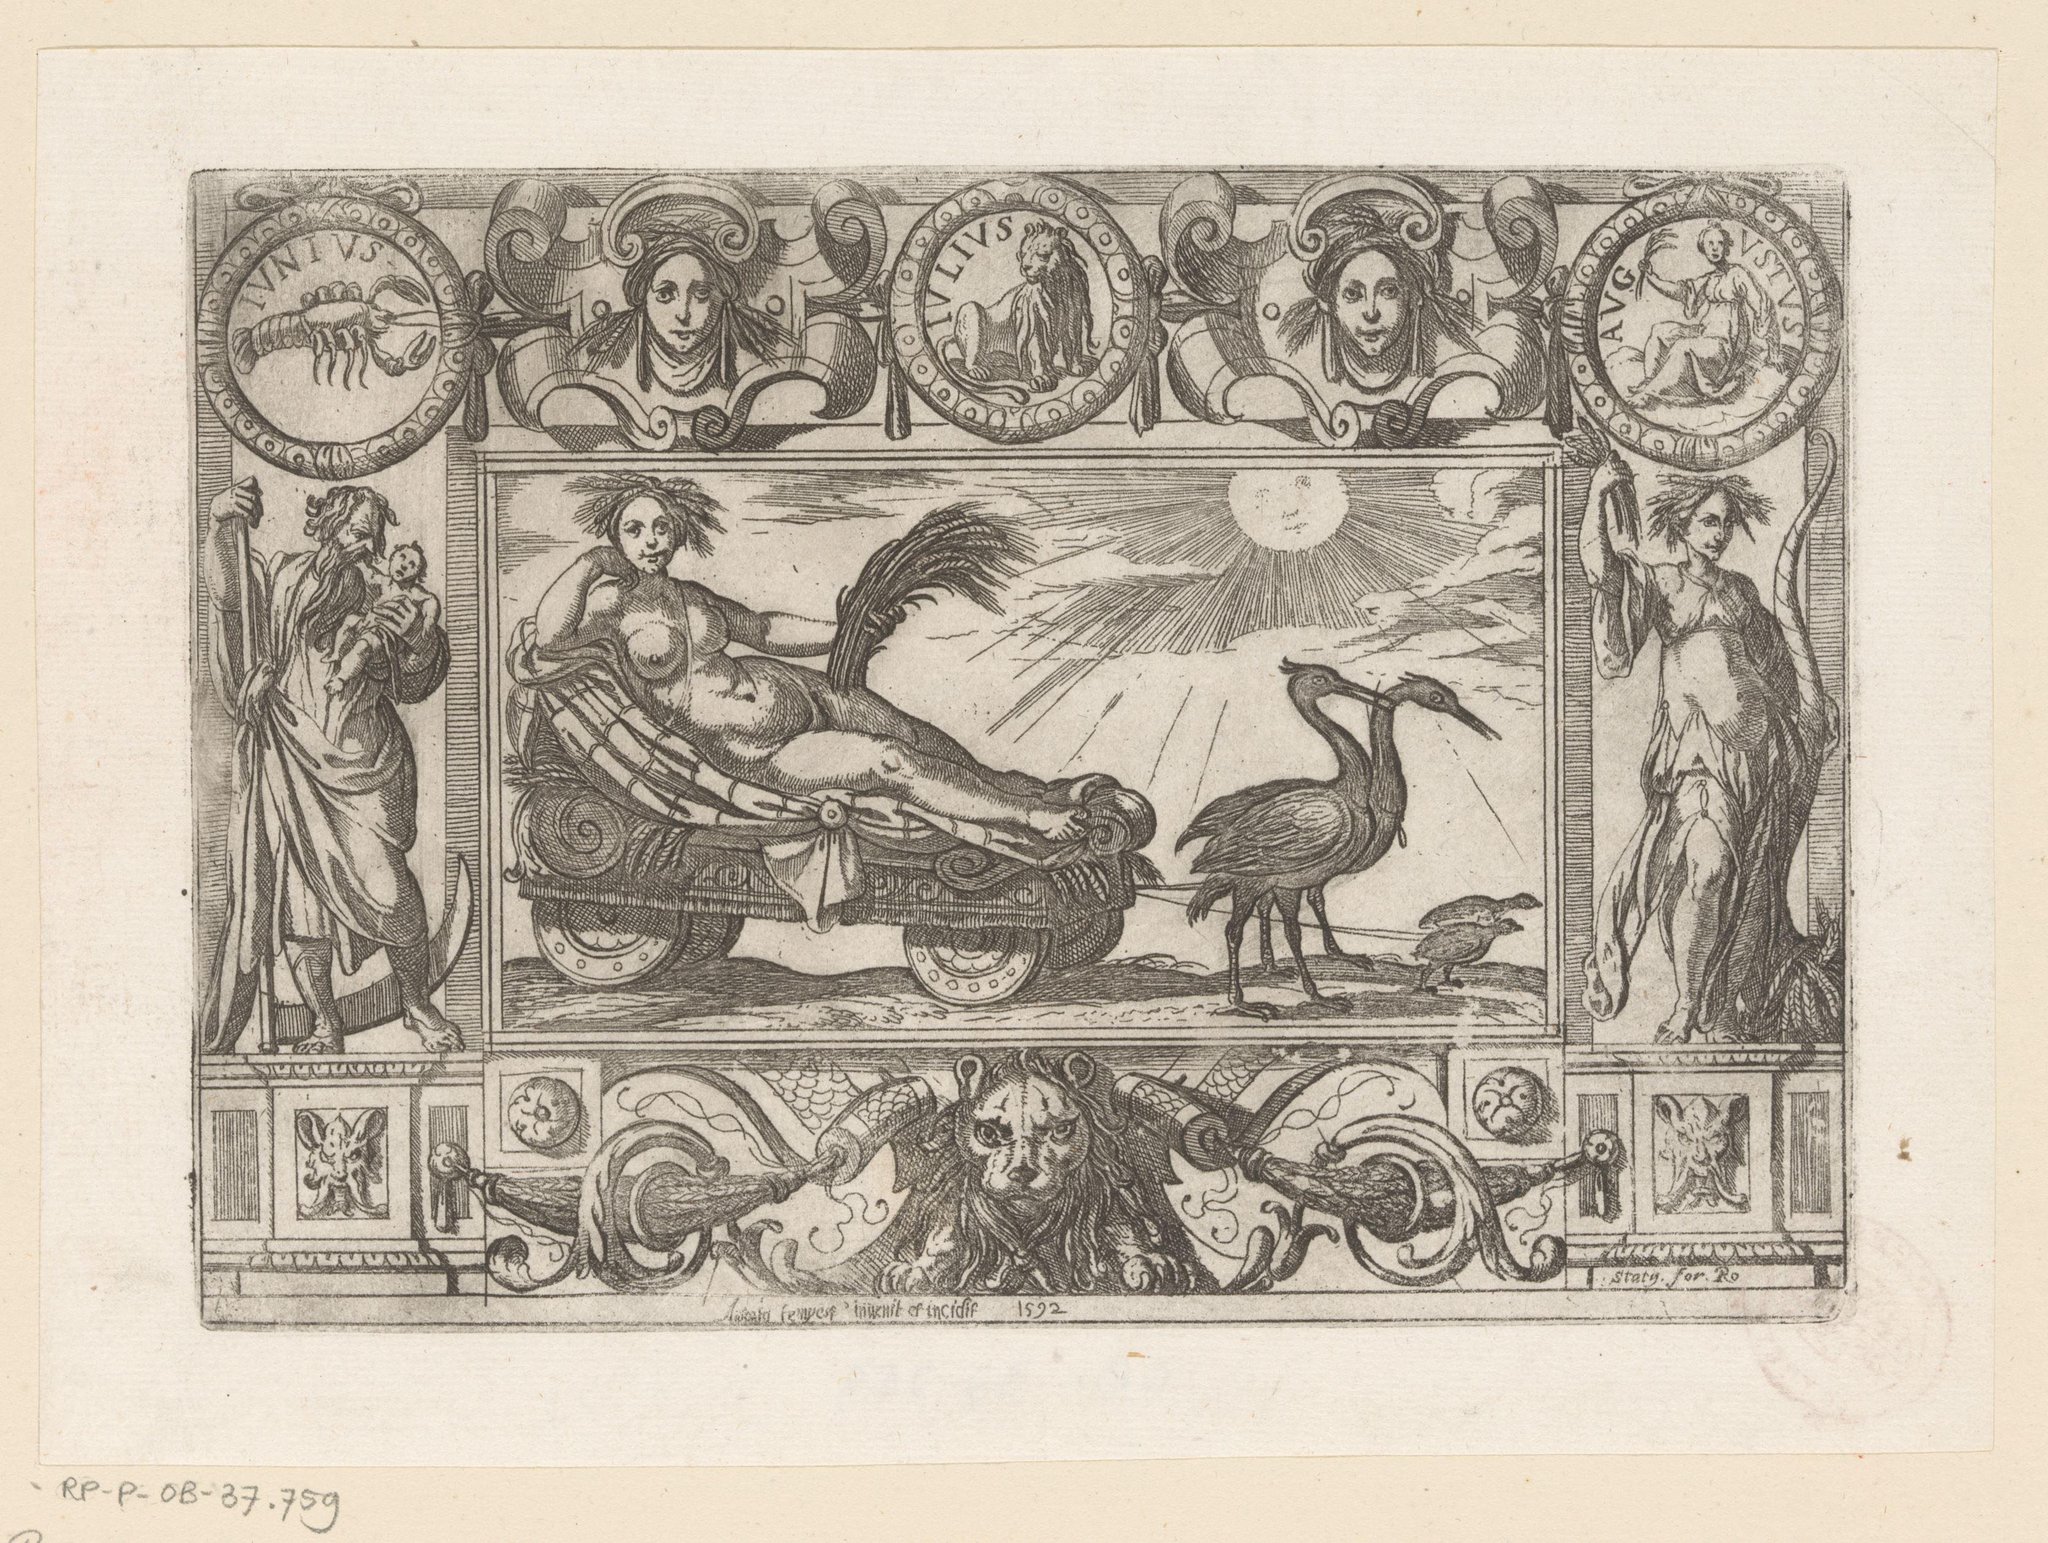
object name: print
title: Zomer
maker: antonio tempesta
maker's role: draughtsman, painter, print maker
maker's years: 1555-1630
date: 1592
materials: paper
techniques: etching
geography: italy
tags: (story of) ceres (demeter), (story of) saturn (cronus) - attributes, summer, 'aestas'; 'estate' (ripa)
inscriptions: collector's mark: Lugt 240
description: Een naakte vrouw met een bundel graan in haar hand op een wagen die wordt voortgetrokken door vogels. De voorstelling wordt omgeven door een ornamentele sierrand met medaillons met de maanden, Ceres en Saturnus.